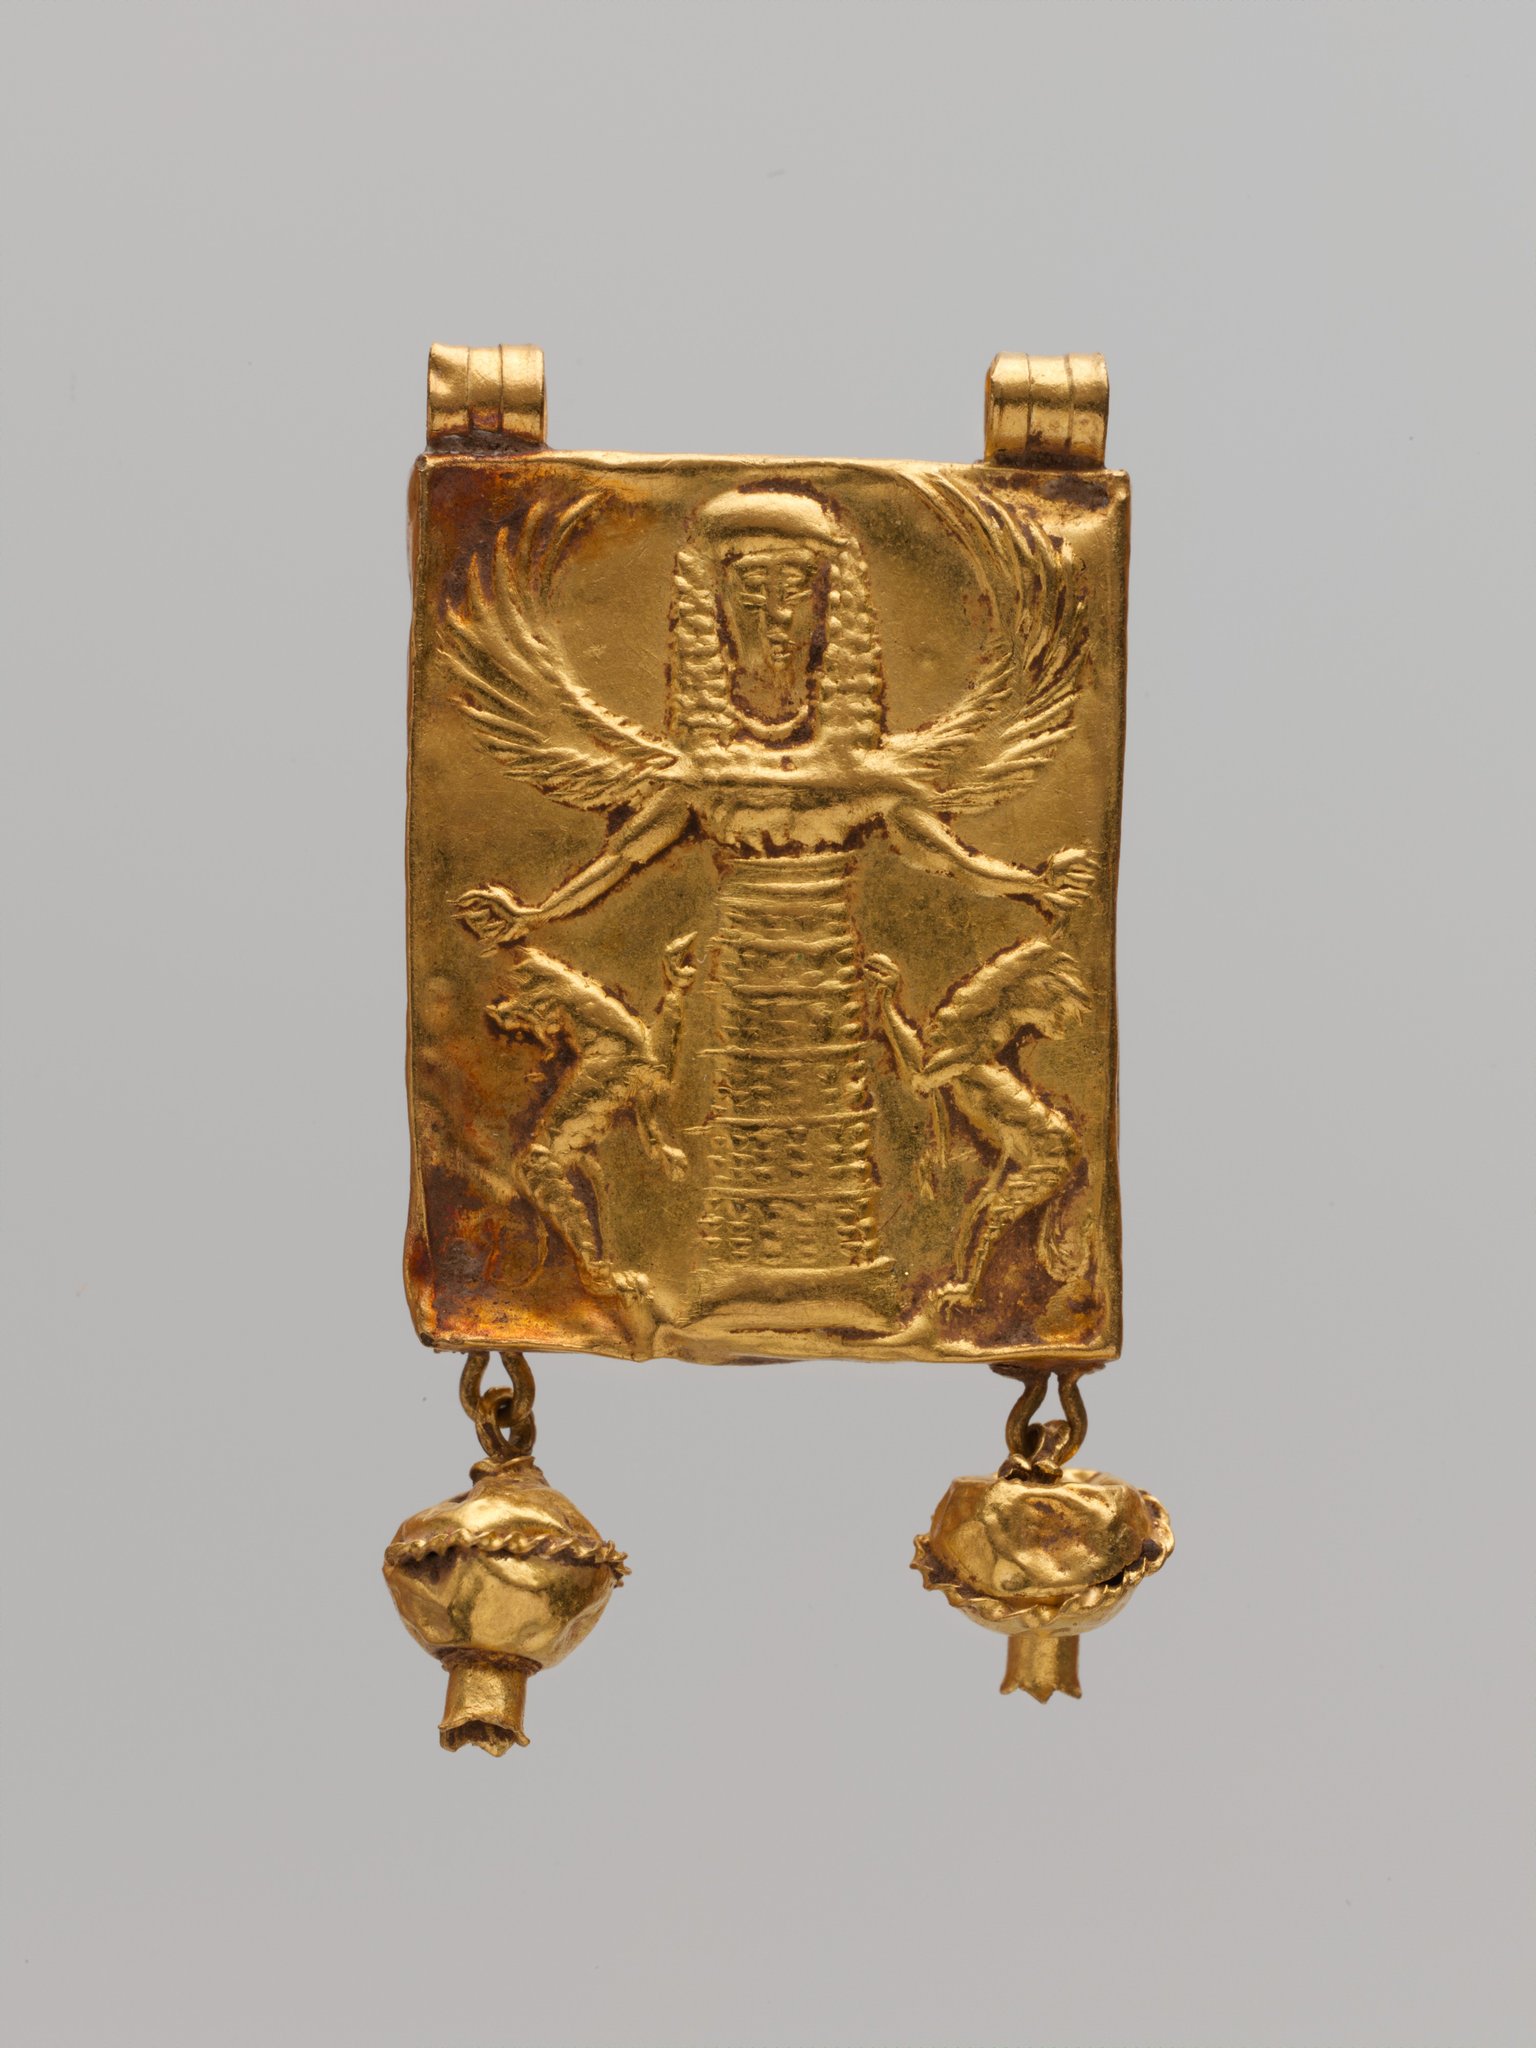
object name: pendant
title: Gold pendant with Mistress of Animals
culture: greek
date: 700-601 BCE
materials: gold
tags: animals